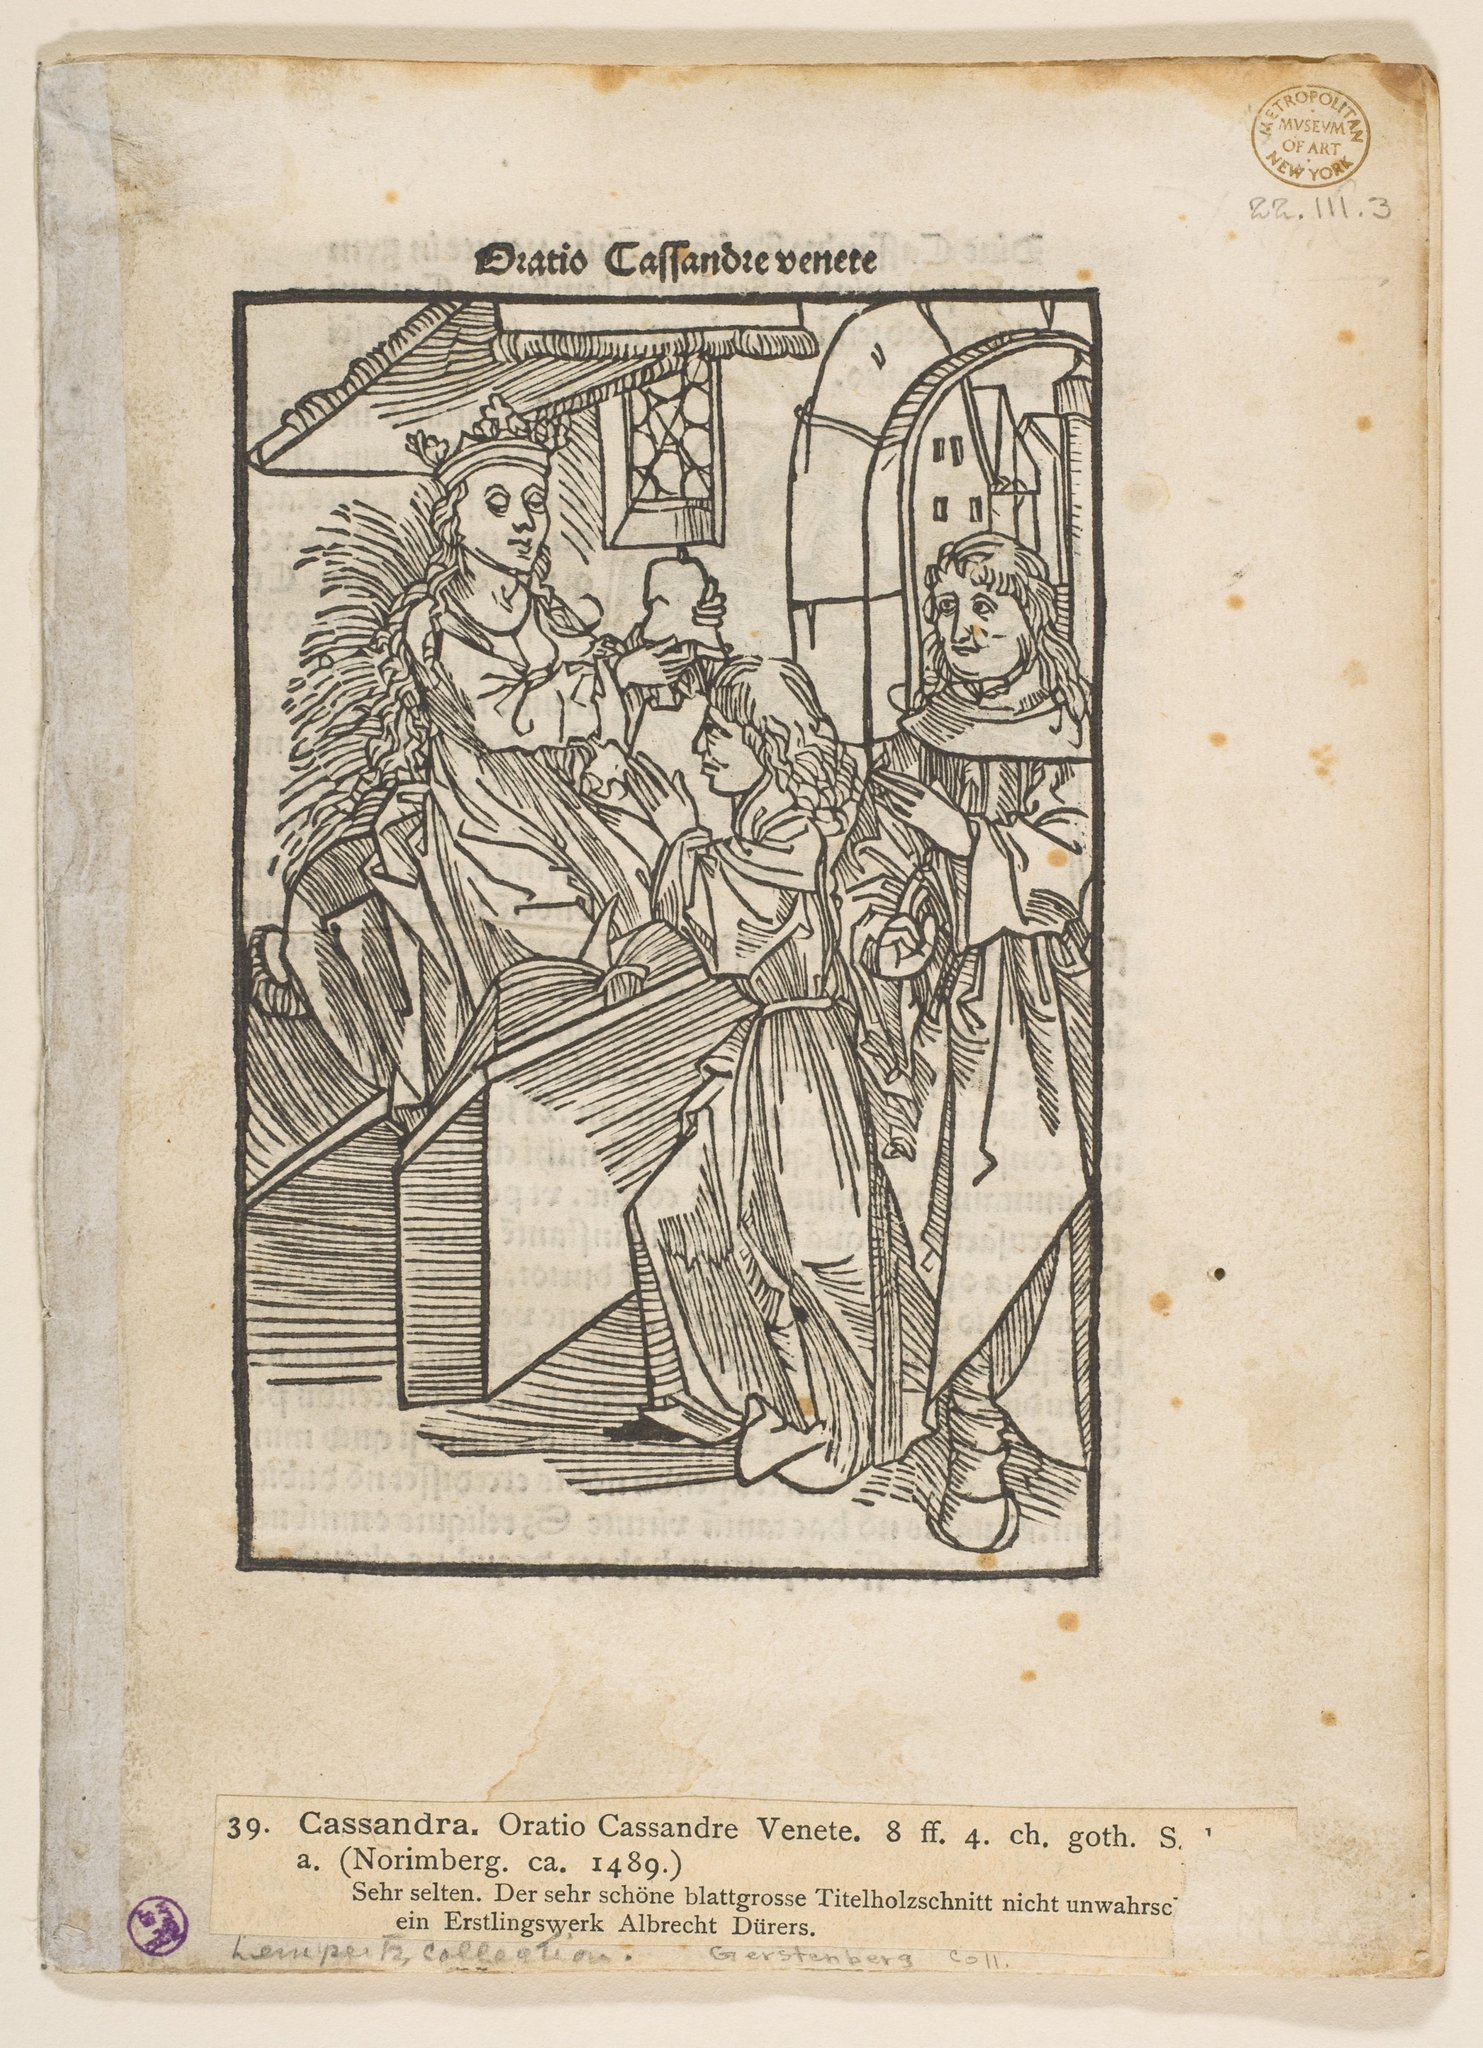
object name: book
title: Oratio Cassandre Venete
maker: peter wagner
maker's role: publisher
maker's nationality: german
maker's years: 15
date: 1489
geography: germany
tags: men,women